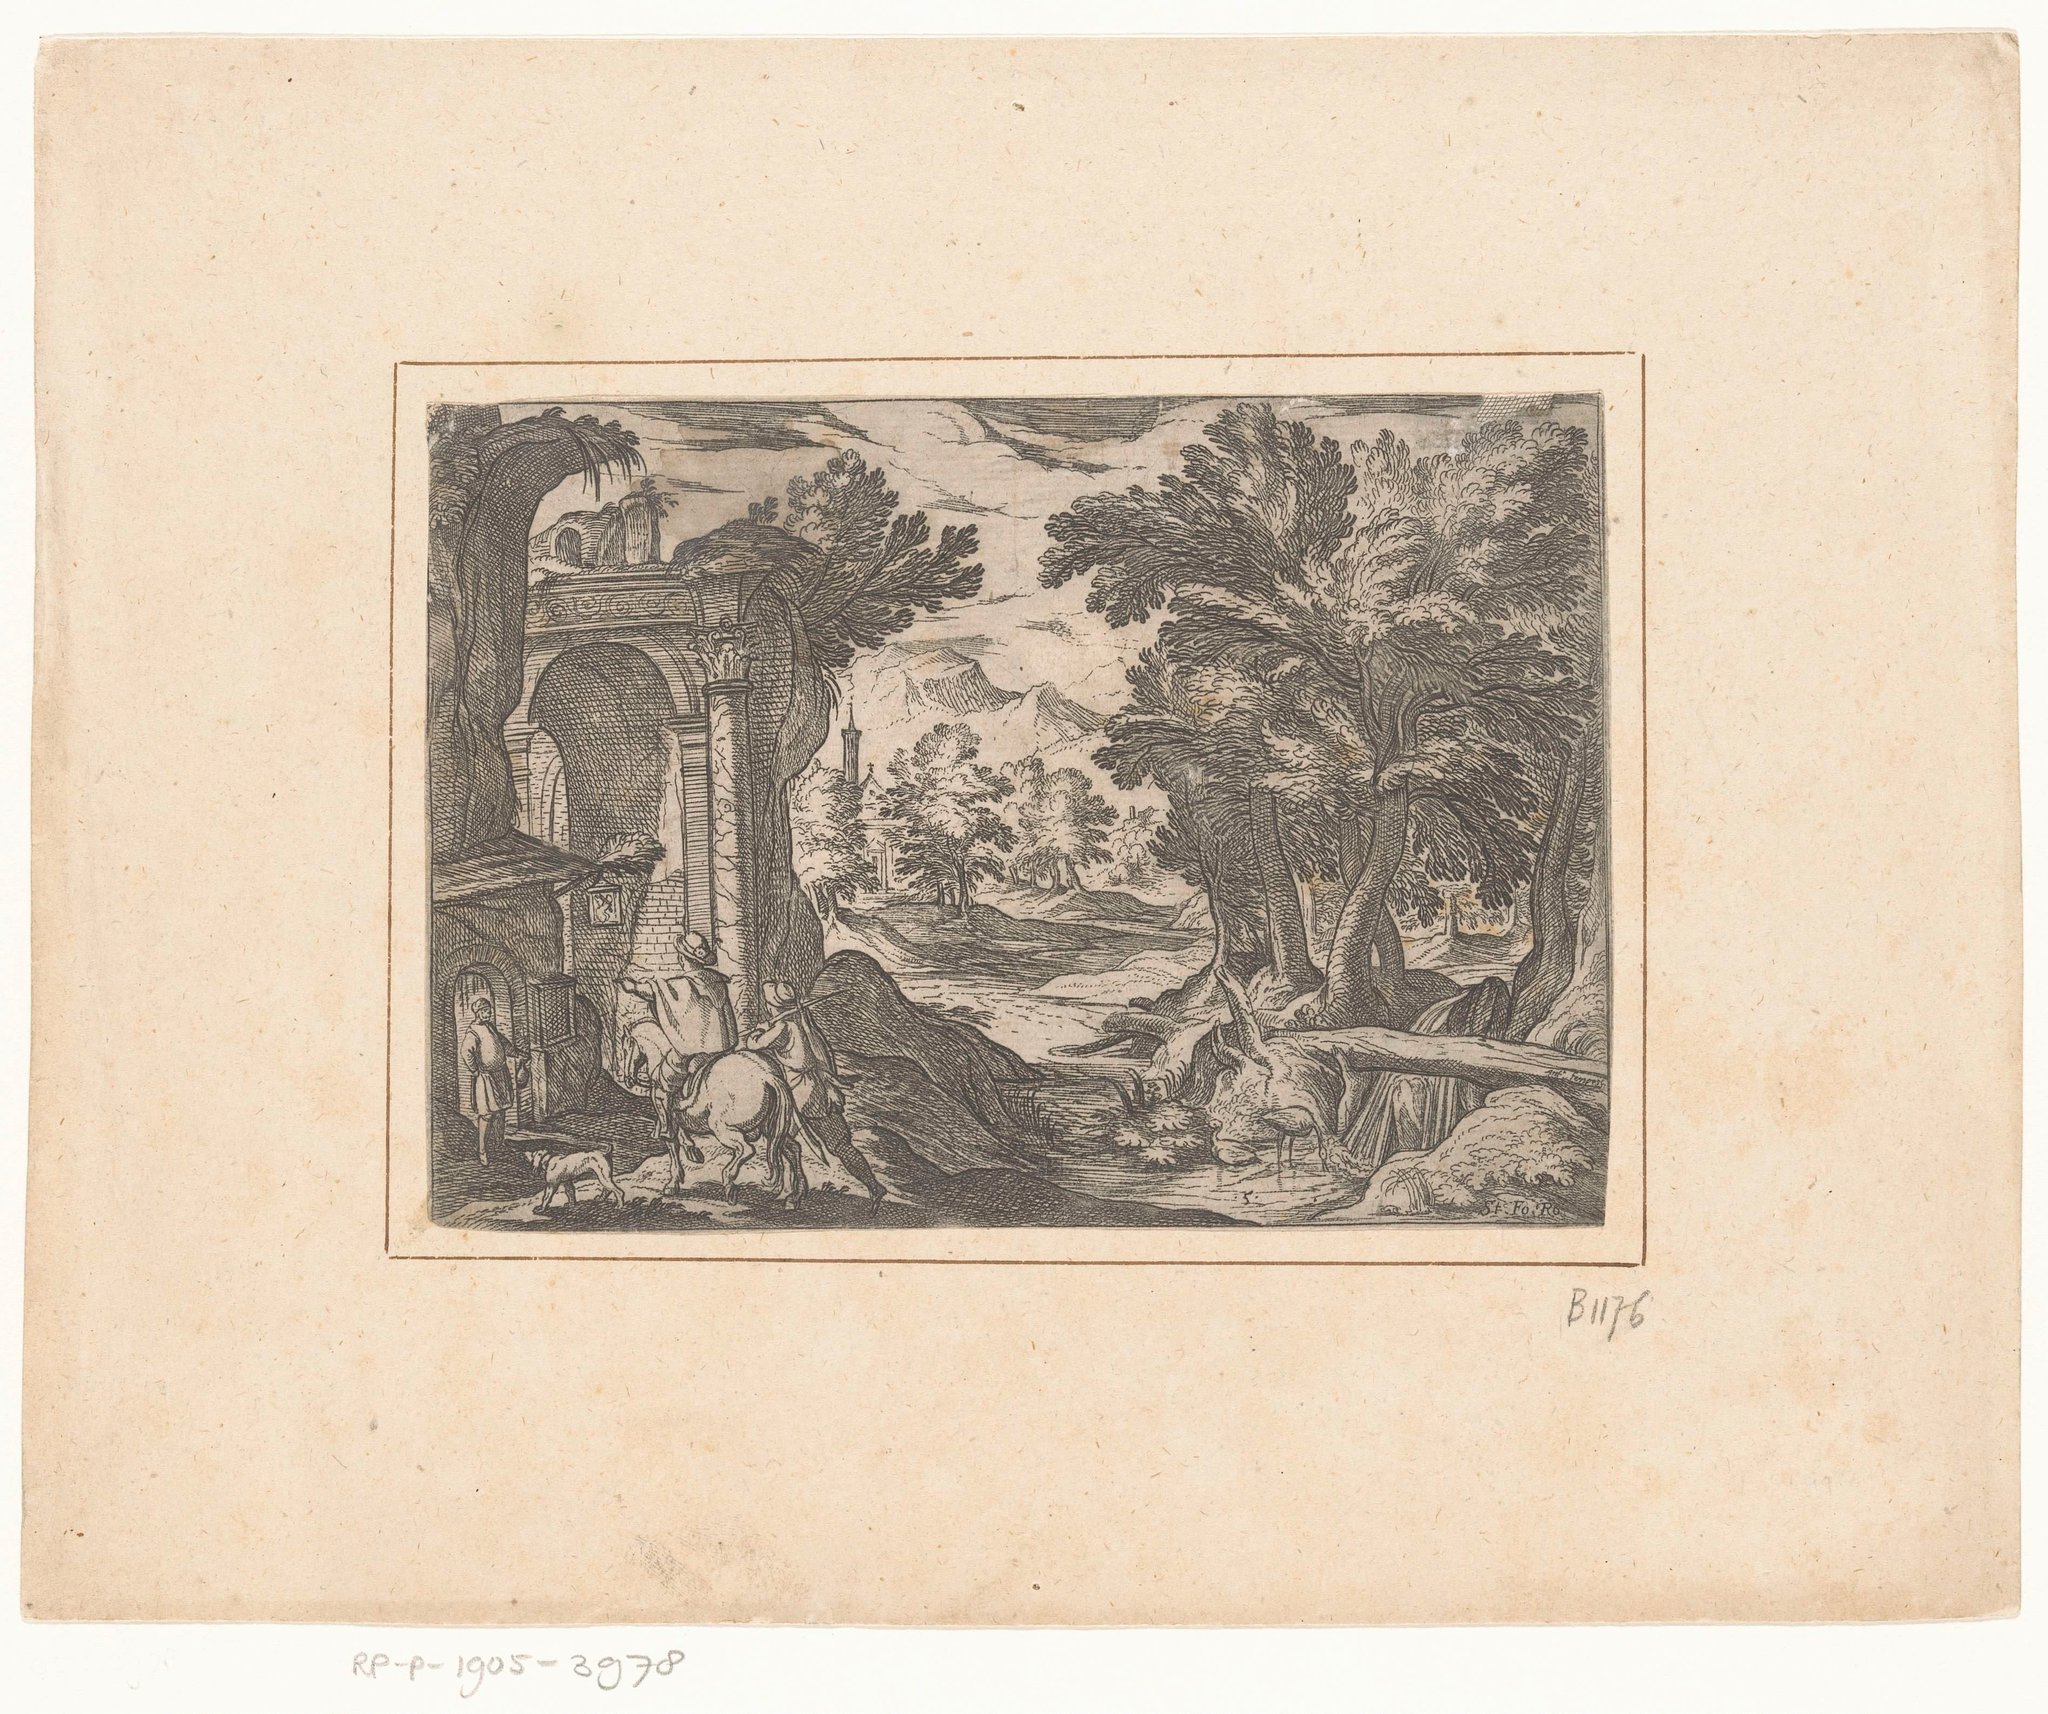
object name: print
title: Landschappen met figuren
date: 1592-1598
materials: paper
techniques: etching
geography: italy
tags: landscape with ruins, hotel, hostelry, inn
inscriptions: collector's mark: Lugt 2228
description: Bergachtig landschap met een ruïne. Voor de ruïne een herberg, waarvoor een man te paard, een tweede man en een hond.